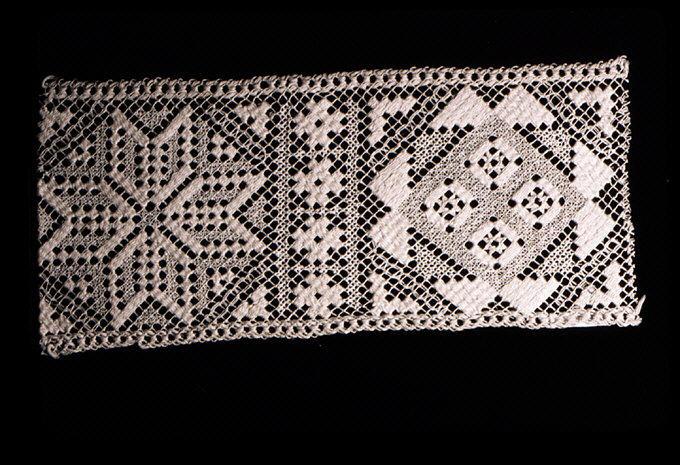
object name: border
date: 1801-1900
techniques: embroidery